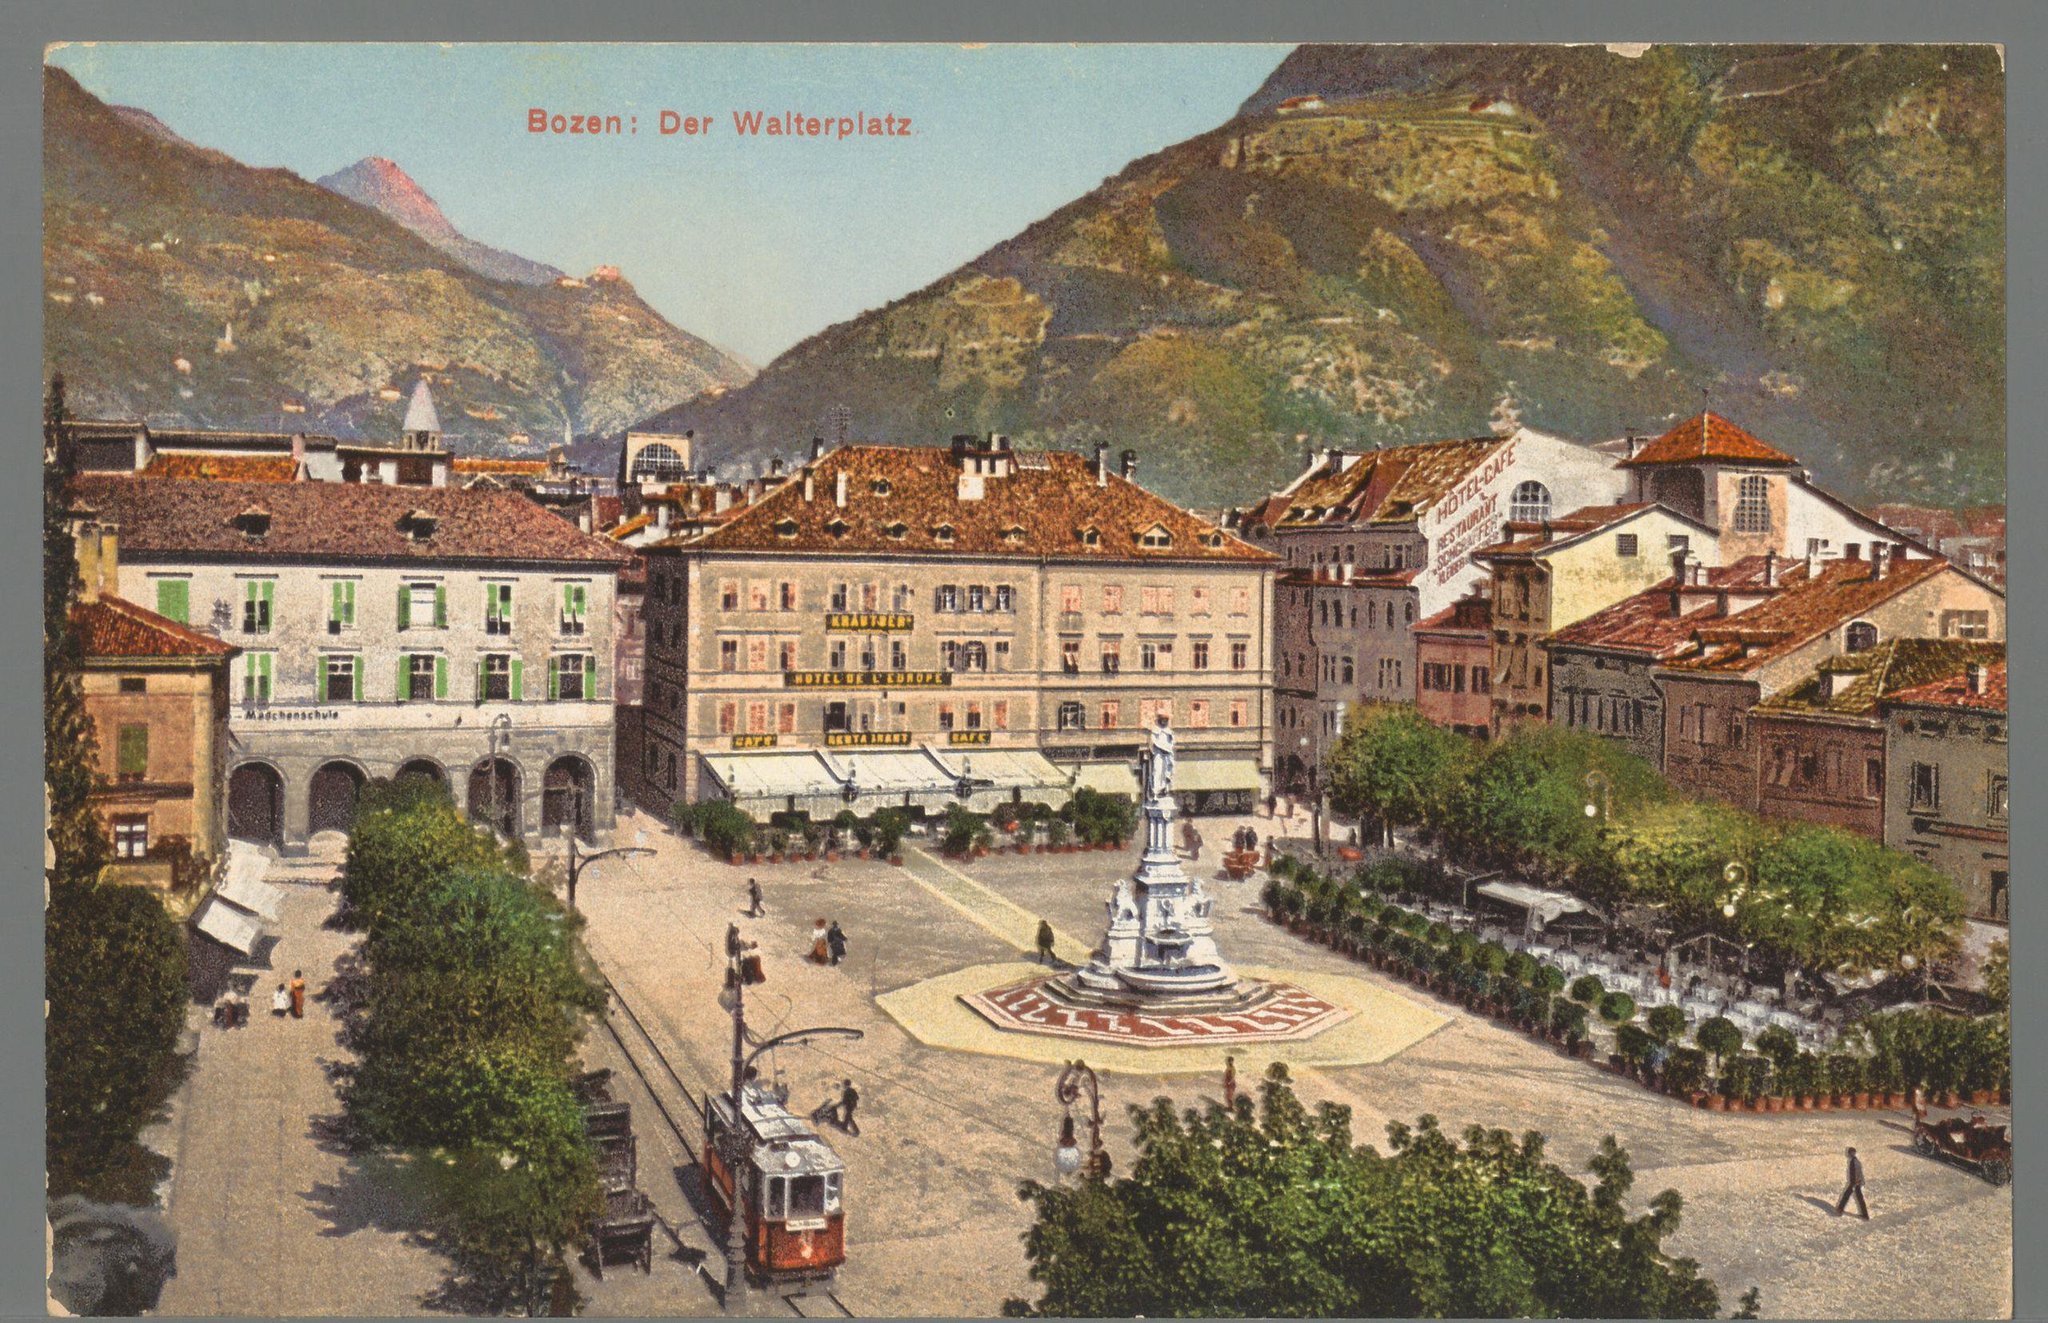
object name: ansichtkaart, prentbriefkaart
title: Bozen. Der Walterplatz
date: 1910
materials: cardboard, photographic process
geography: bolzano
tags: square, place, circus, etc. (+ city(-scape) with figures, staffage), mountains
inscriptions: date